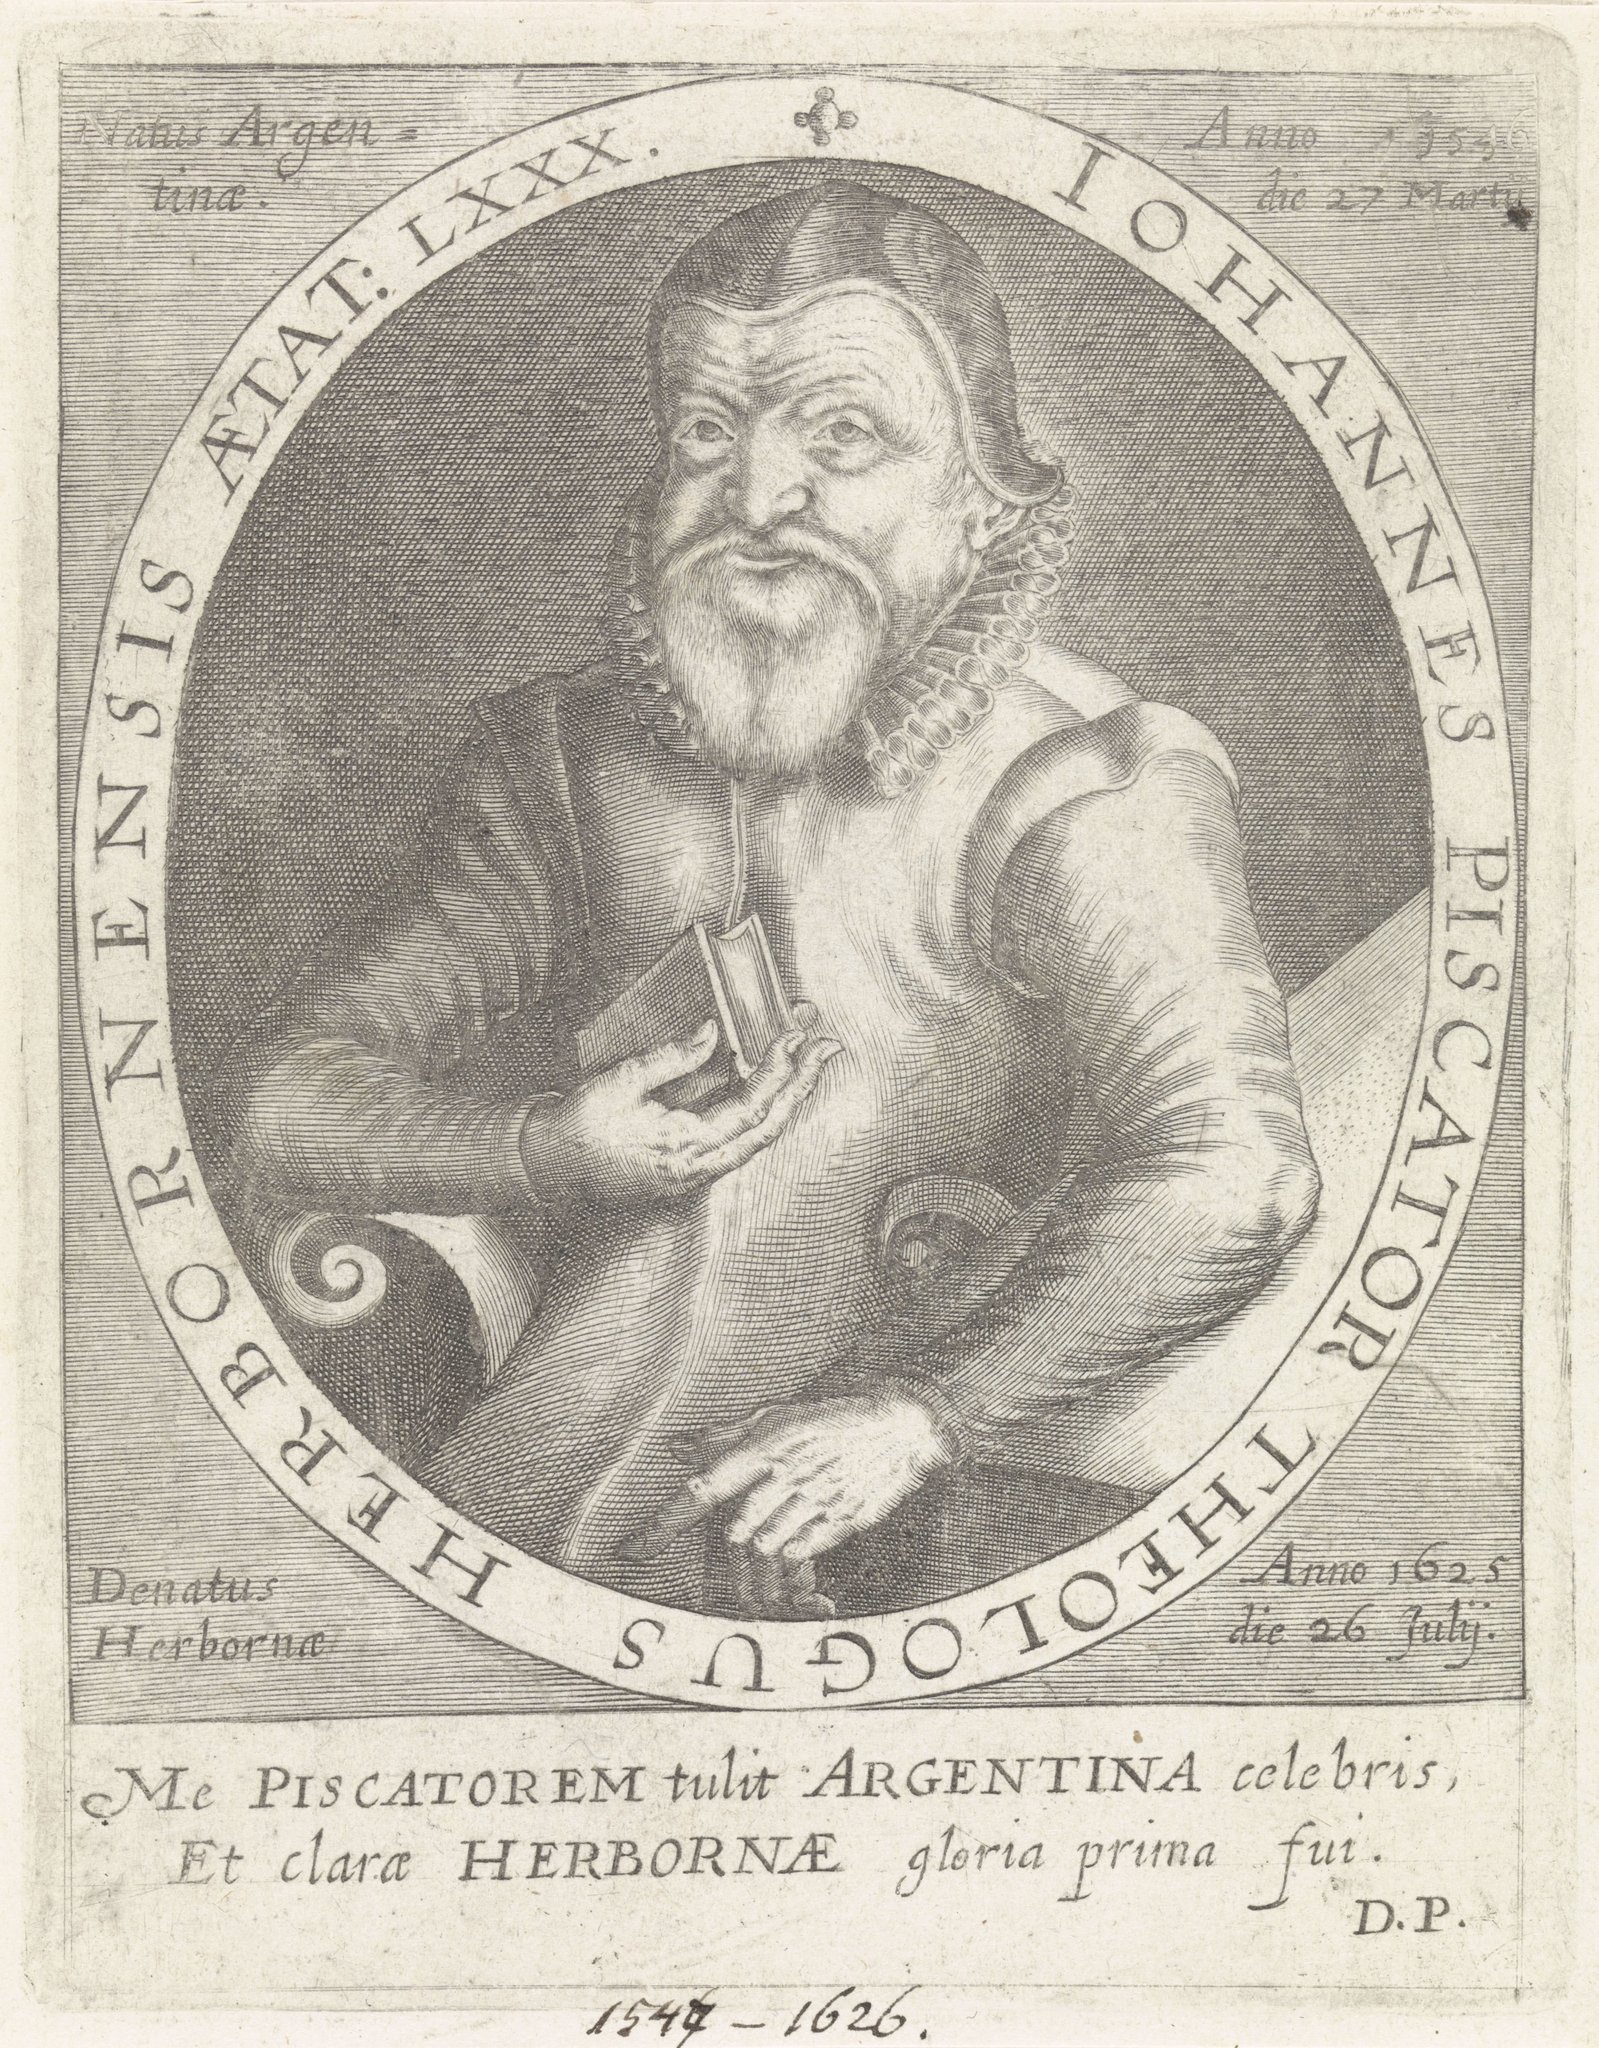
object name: book illustration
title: Portretten van beroemde Europese wetenschappers, humanisten en geestelijken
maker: paul de zetter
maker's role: print maker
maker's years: 1600-1667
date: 1628-1645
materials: paper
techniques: engraving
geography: germany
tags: straatsburg (frankrijk), herborn, theoloog, johannes piscator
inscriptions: inscription: ‘1547-1626’, collector's mark: Lugt 2228, inscription: ‘De gratia Dei 7.’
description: Prent gebruikt in een van de edities van Jean-Jacques Boissard. Boissard, Jean-Jacques. Bibliotheca sive Thesaurus Virtutis et Gloriae: In quo continentus Illvstrivm Ervditione & doctrina Virorum Effigies & Vitae (...). Frankfurt, [1628]. Zie Hollstein Dutch, deel LVIII, p. 86-87.